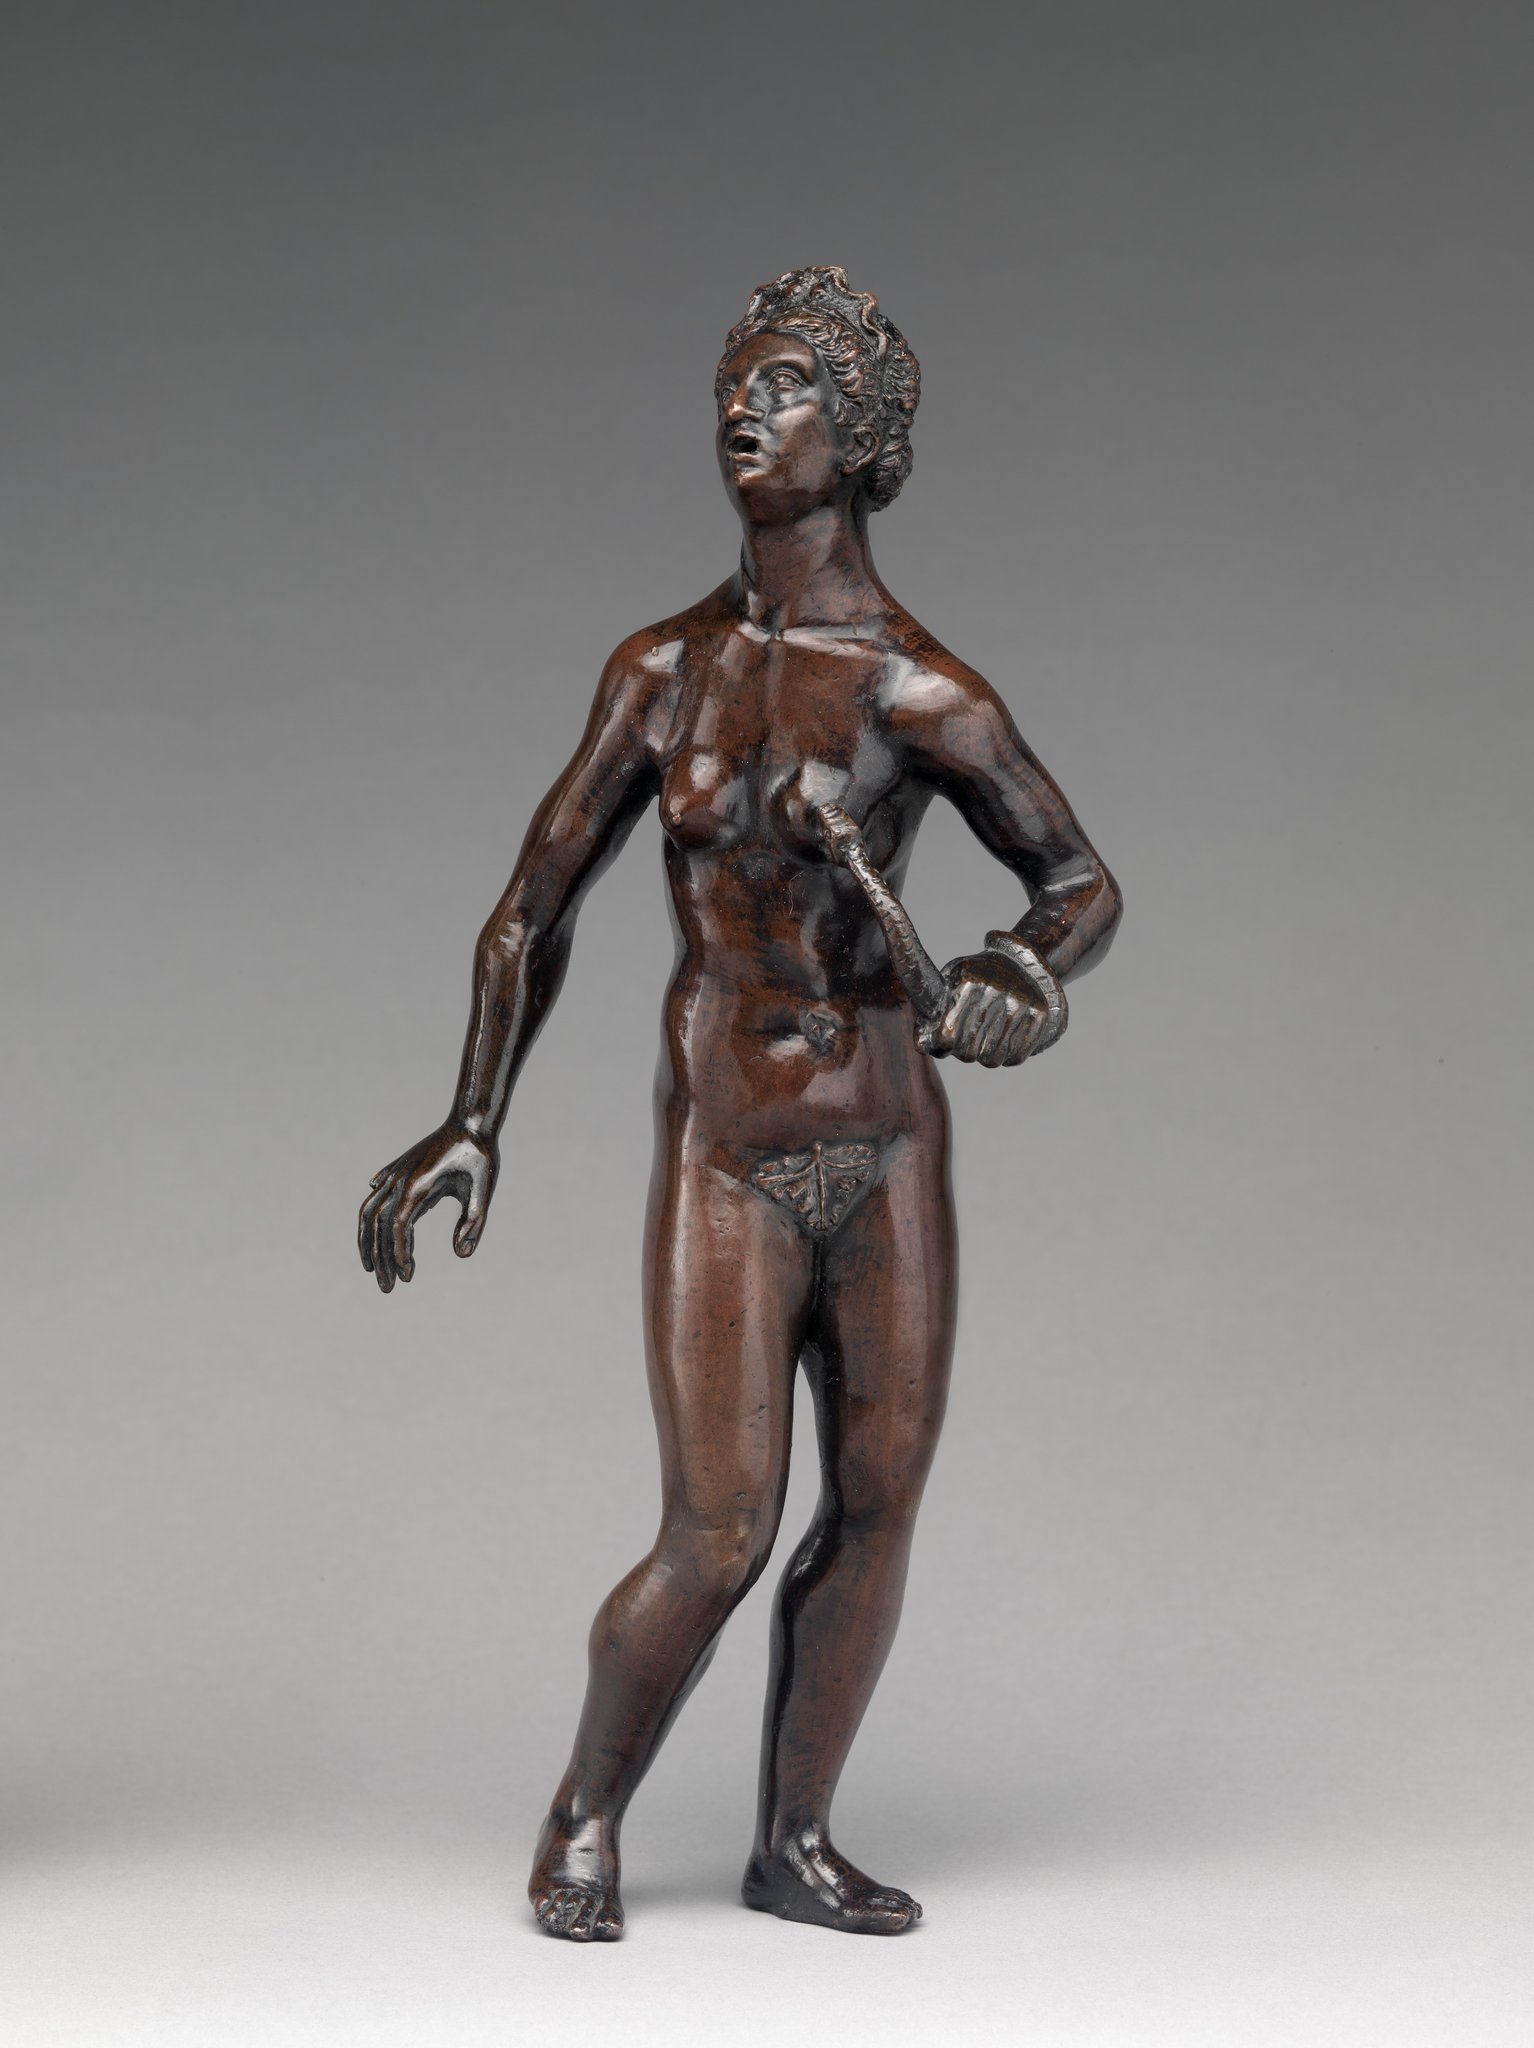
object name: statuette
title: Cleopatra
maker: severo calzetta da ravenna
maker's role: artist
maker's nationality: italian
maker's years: 1496-1543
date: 1501-1525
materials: bronze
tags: cleopatra,female nudes